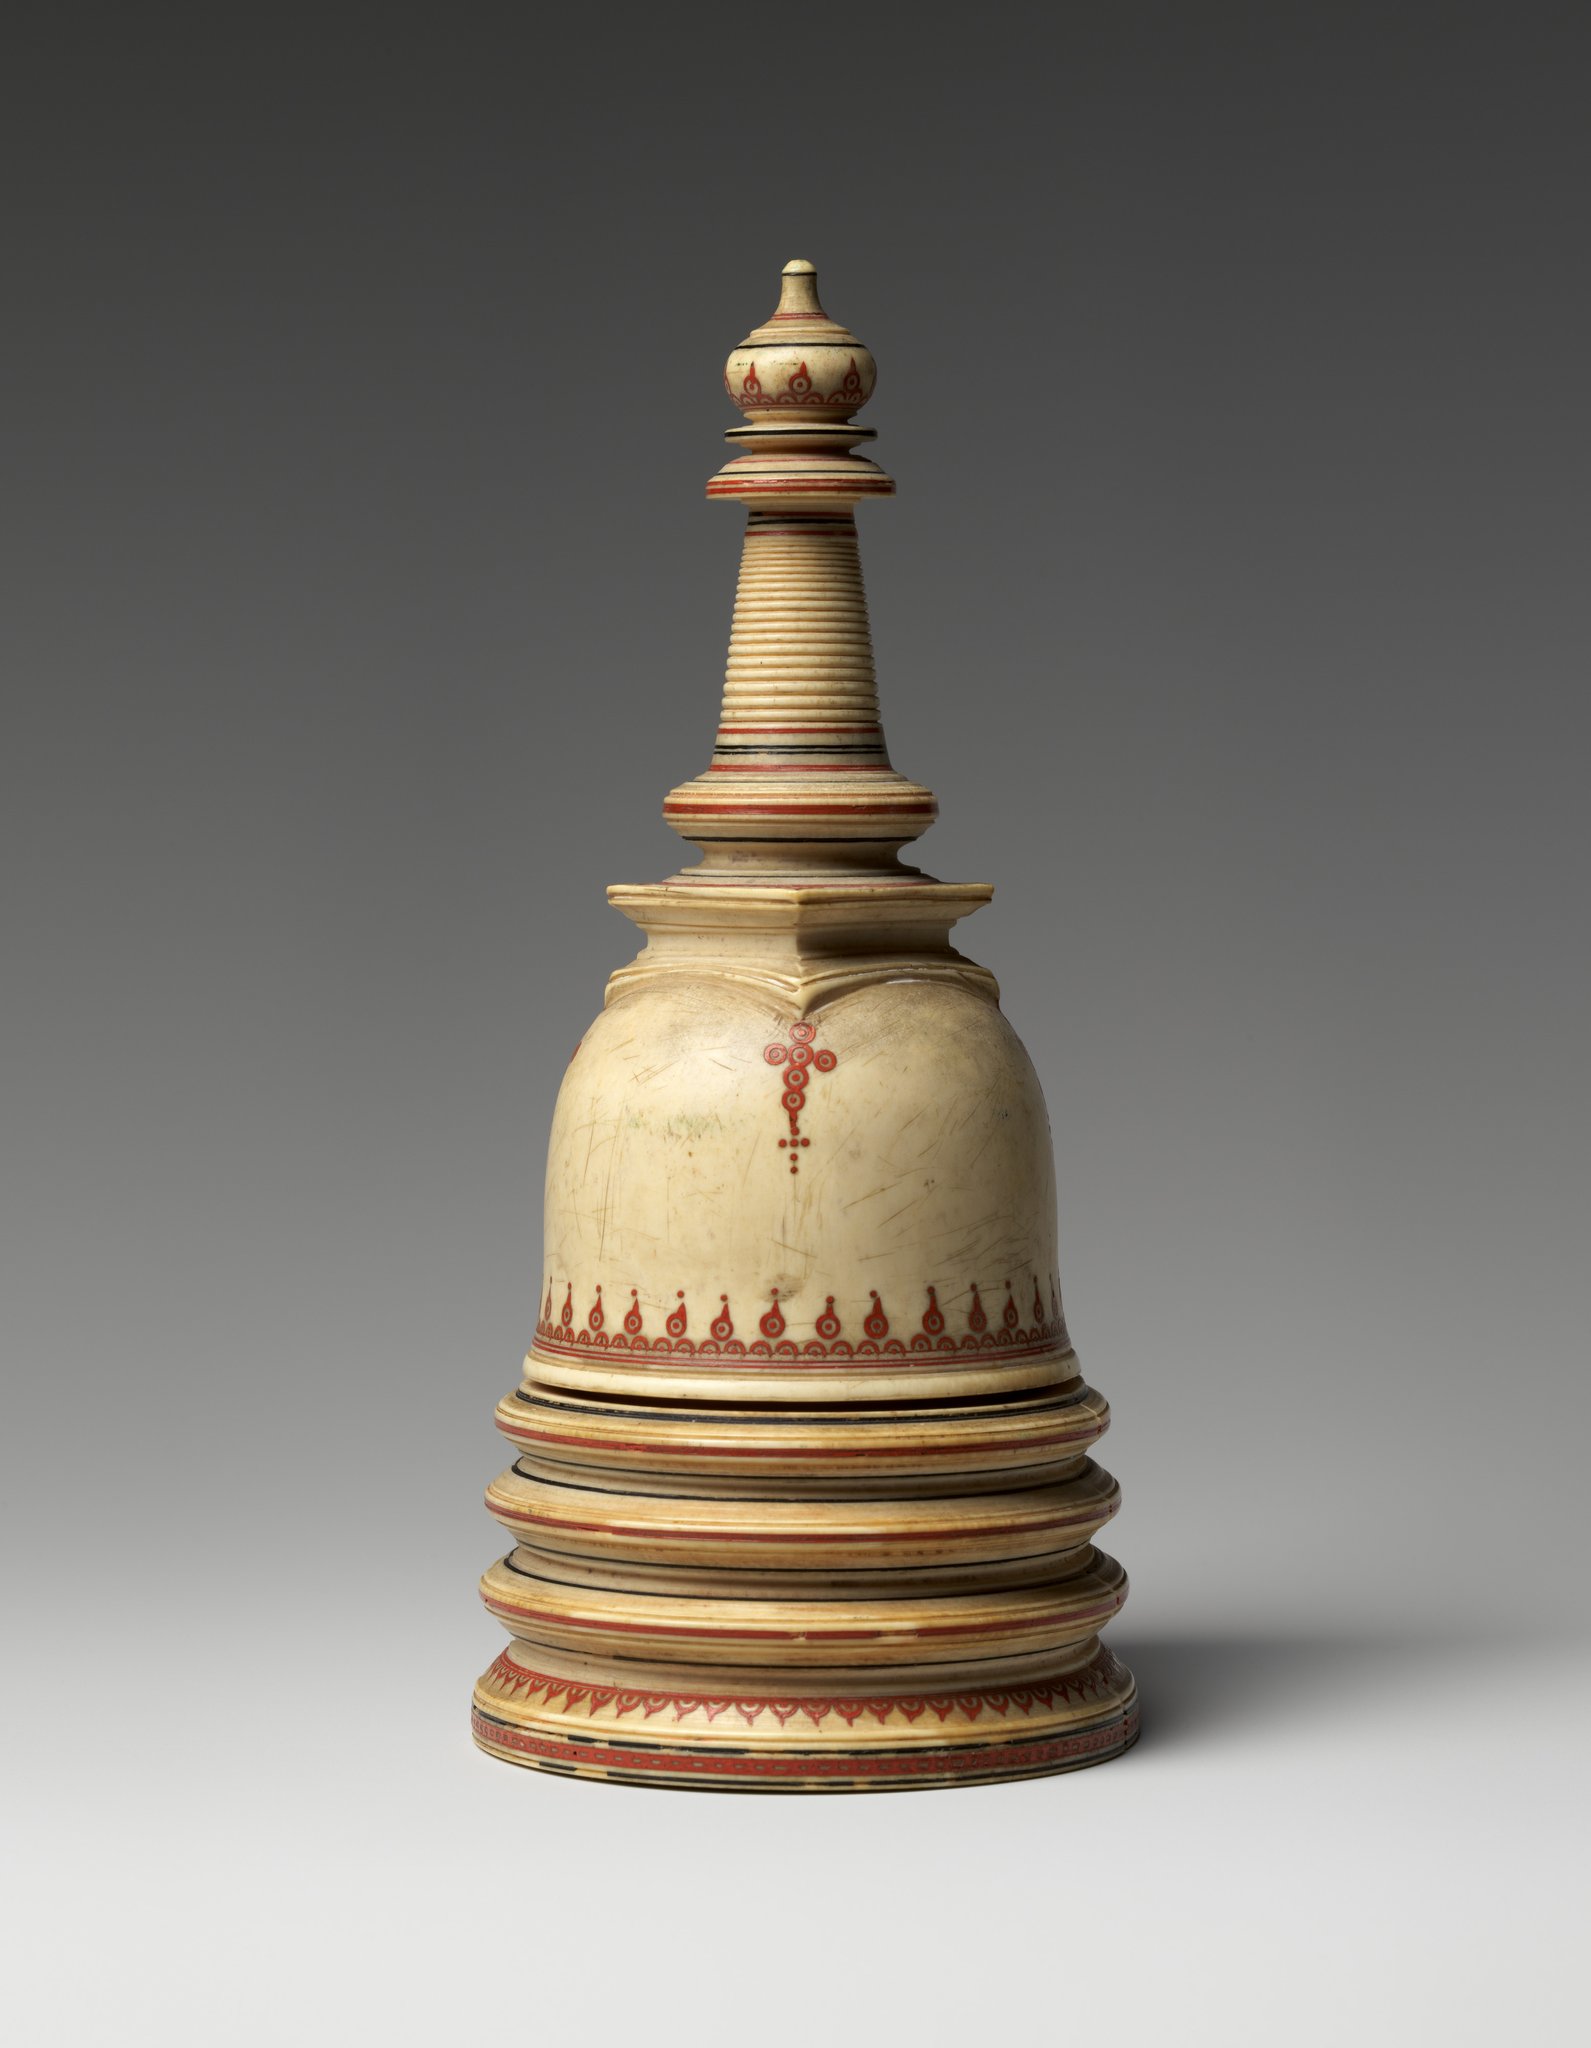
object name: reliquary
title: Reliquary in the Shape of a Stupa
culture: sri lanka, kandy district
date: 1701-1800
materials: ivory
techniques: engraving, painting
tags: stupas